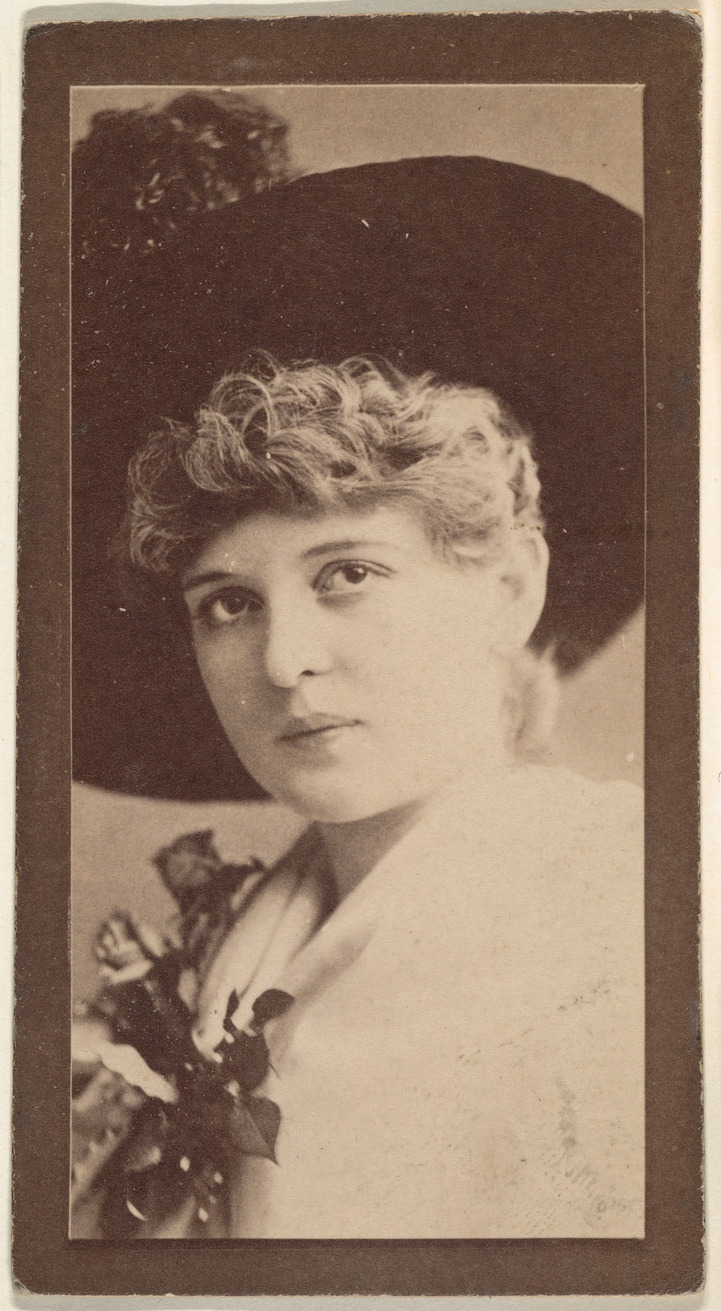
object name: photograph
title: Portrait of actress wearing dark wide-brimmed hat, from the Actresses series (N668)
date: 1888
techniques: albumen silver print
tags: portraits,women,actresses